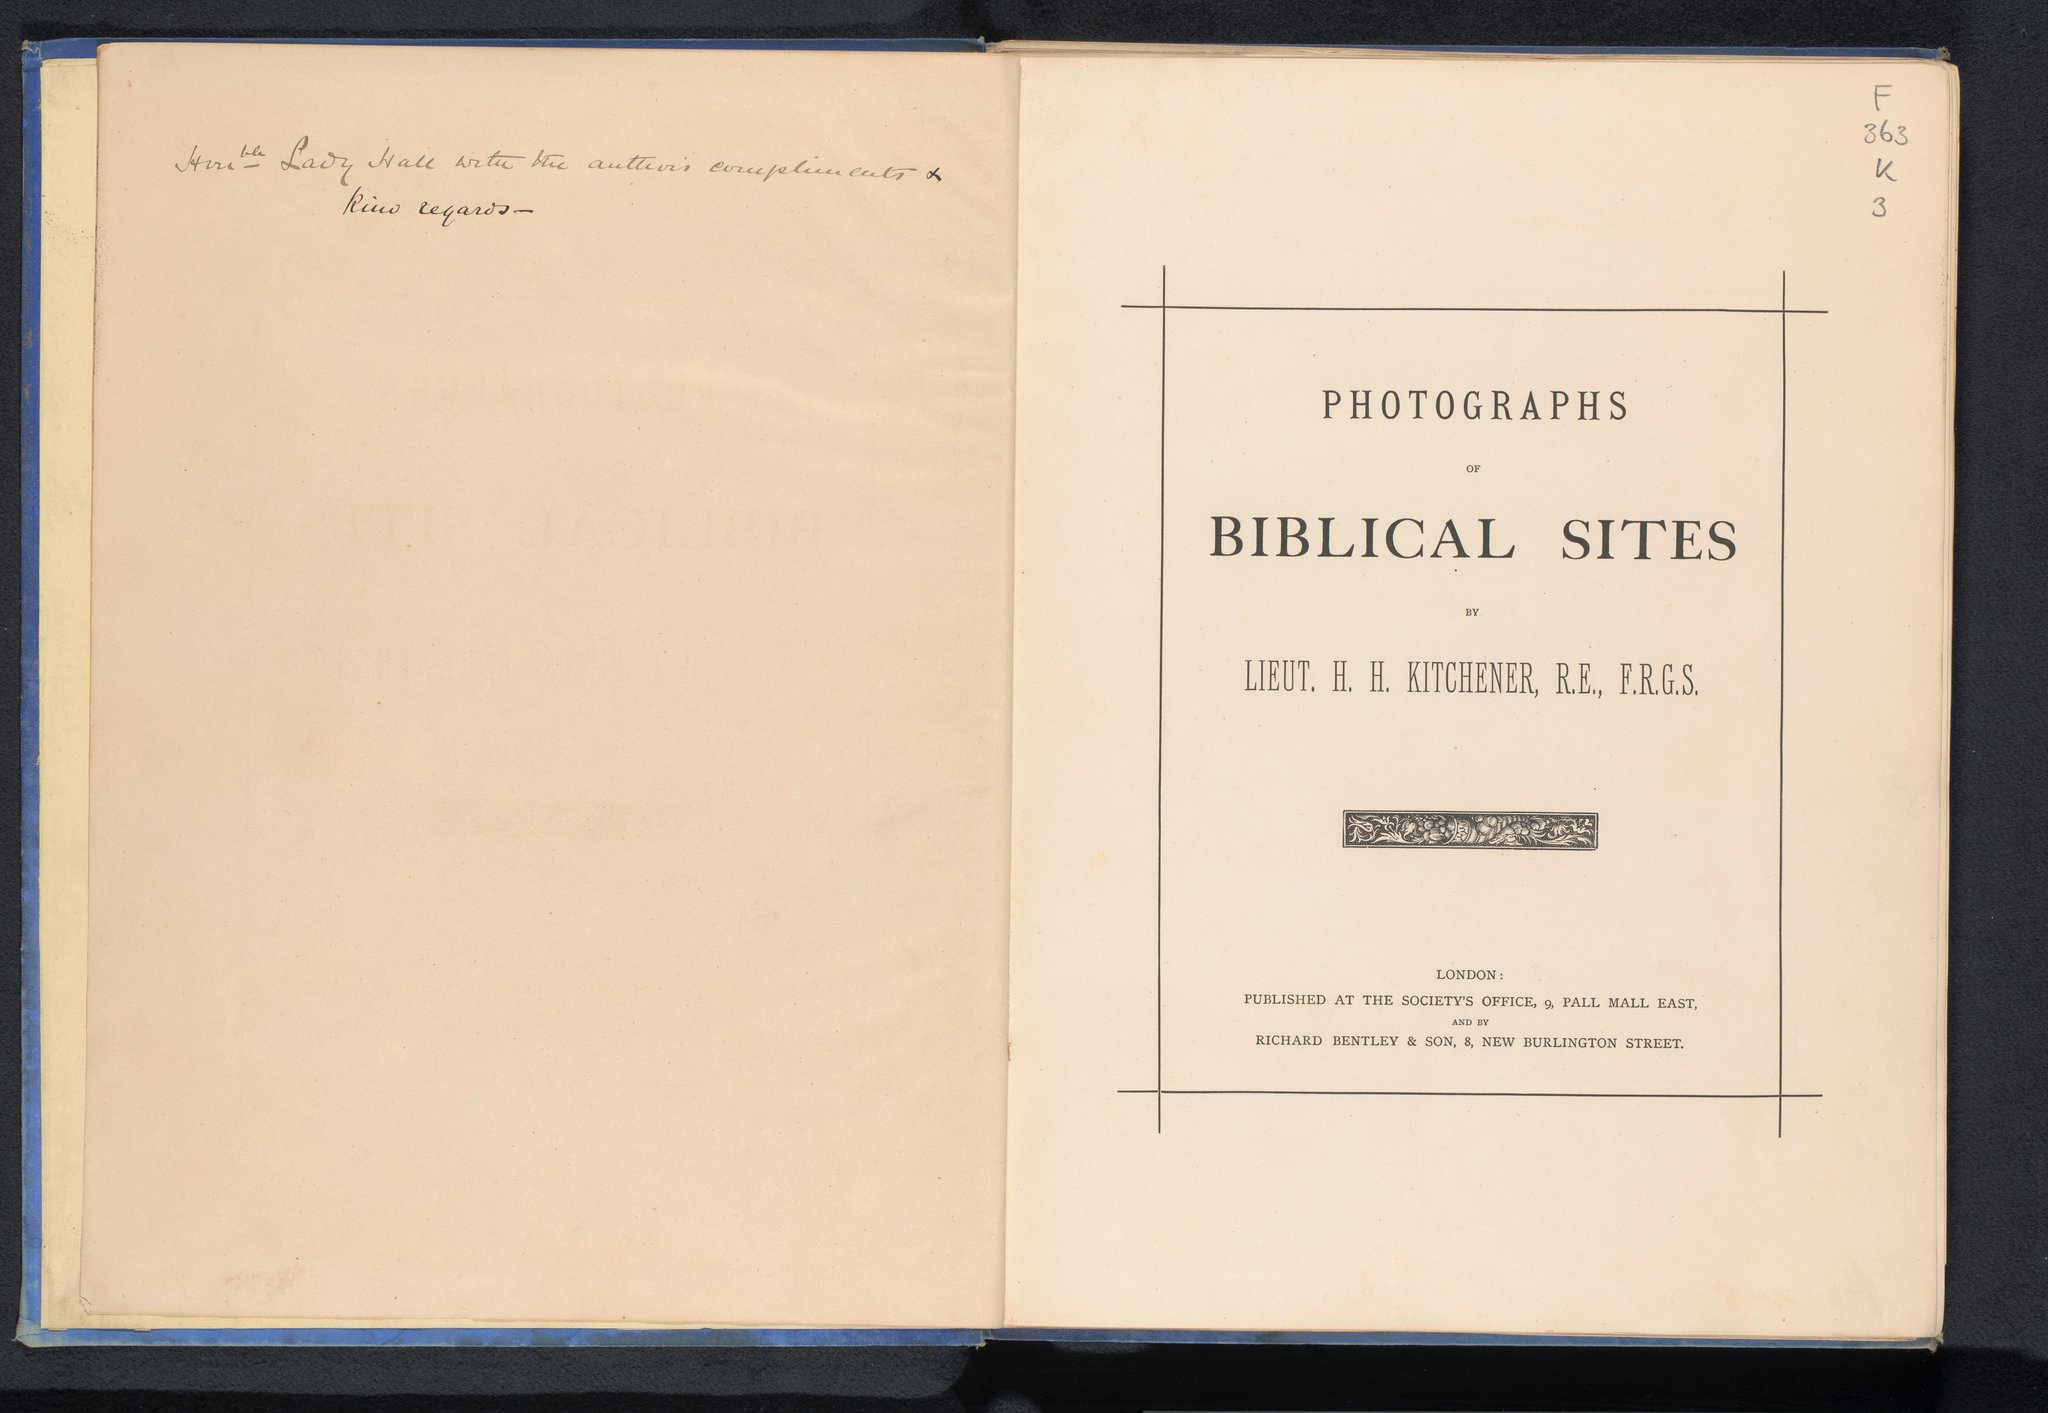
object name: book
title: Photographs of biblical sites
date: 1875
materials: cardboard, leather, linen, paper, photographic support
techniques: albumen print, printing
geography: london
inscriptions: date: ‘MAY 1994’, annotation: ‘(...) authors compliments x kind regards’